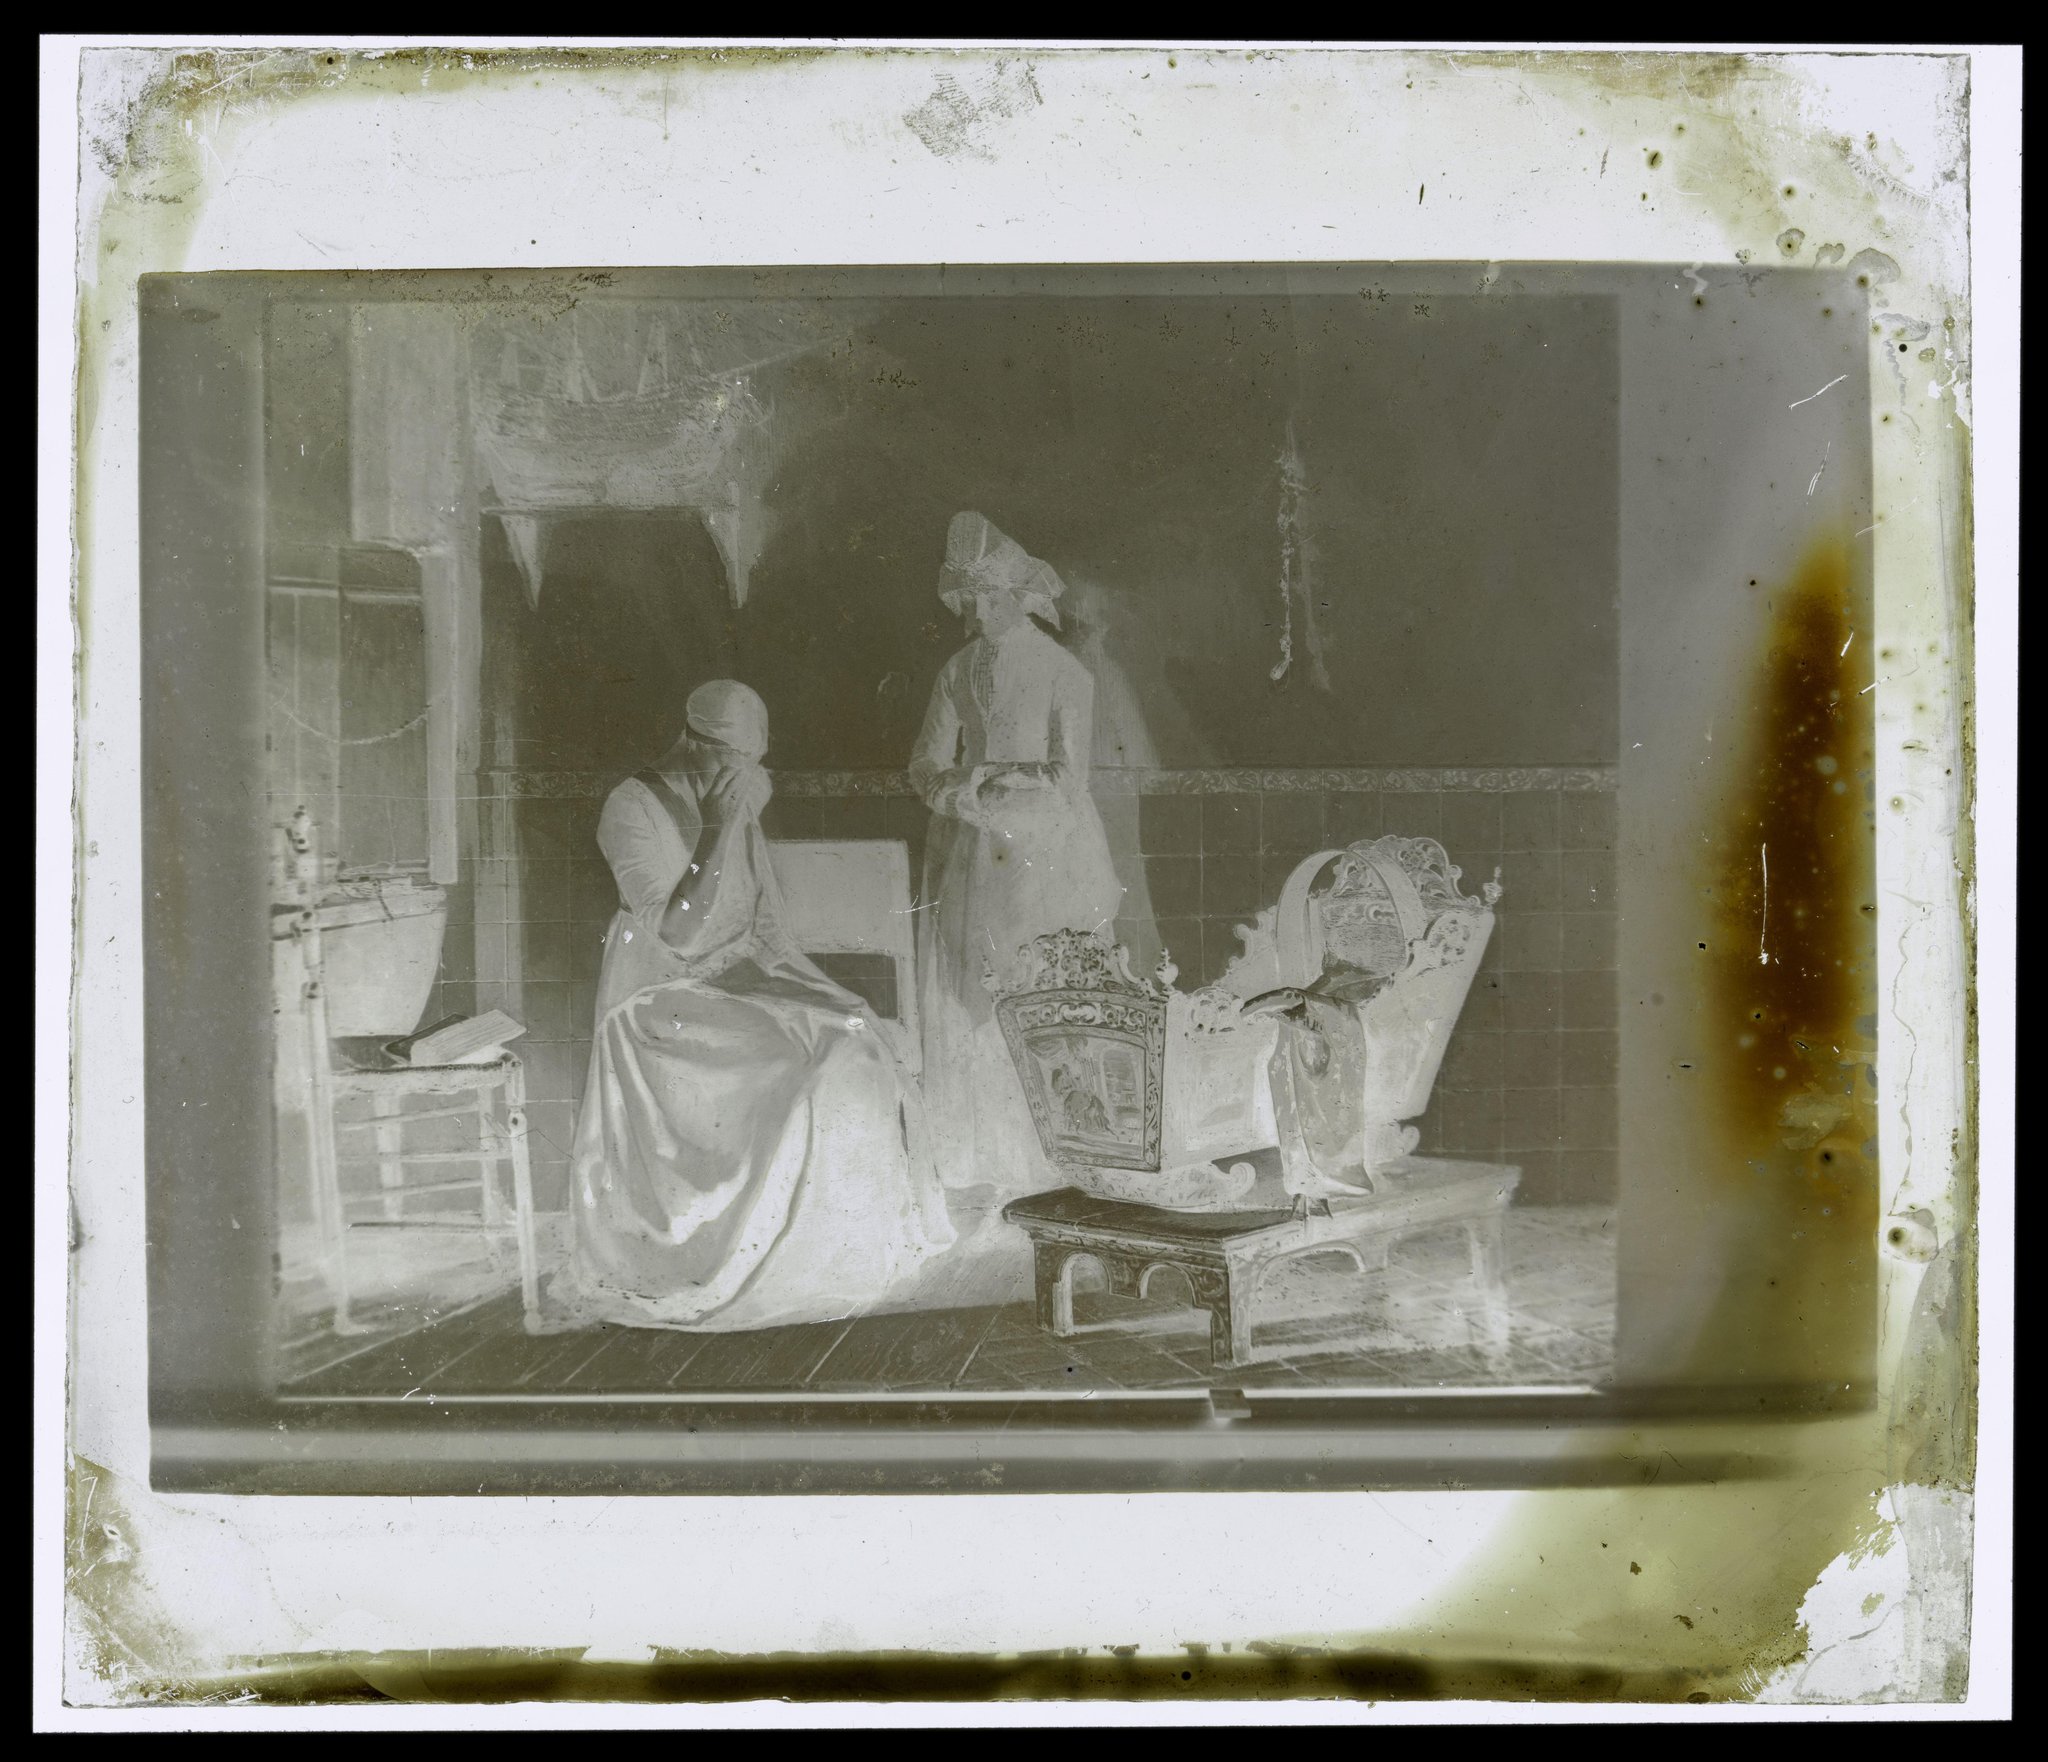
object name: glasnegatief, glasplaatnegatief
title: Fotoreproductie van een wenende vrouw bij een ledikant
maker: laurens lodewijk kleijn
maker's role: draughtsman, painter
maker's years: 1826-1909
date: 1865-1900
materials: glass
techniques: collodion process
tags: adult woman, weeping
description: Onderdeel van een groep glasnegatieven uit de nalatenschap van de schilder Laurens Lodewijk Kleijn, met stillevens, portretten, zelfportretten en kunstreproducties.